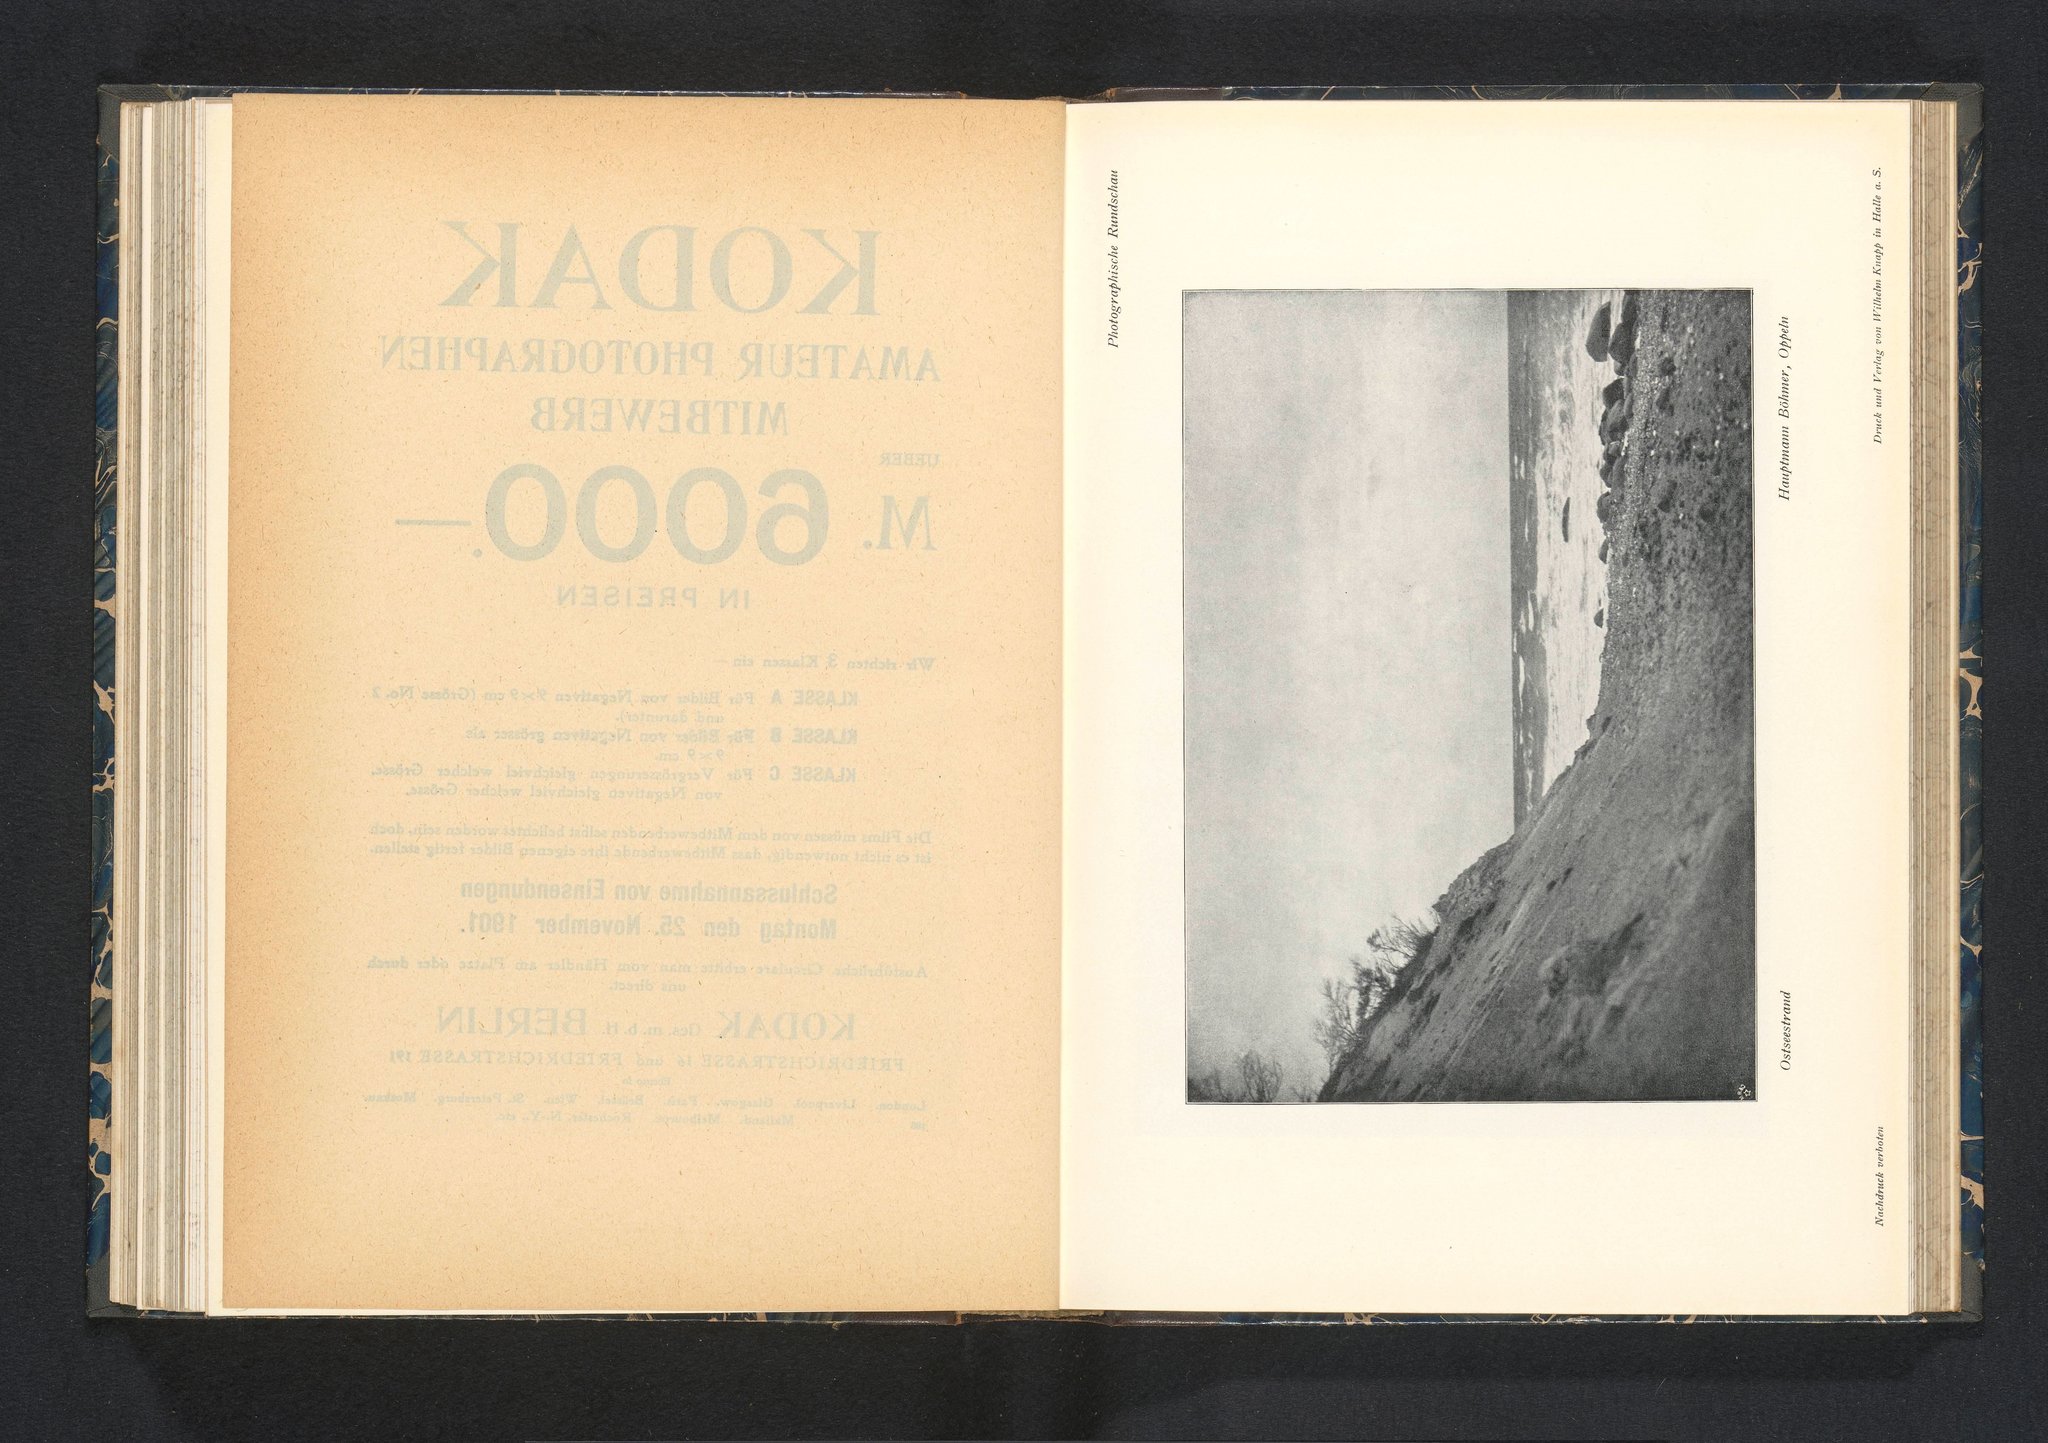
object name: photomechanical print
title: Kustlandschap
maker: hauptmann a. böhmer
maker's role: draughtsman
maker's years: 1860-1908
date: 1896-1901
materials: paper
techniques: autotype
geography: halle an der saale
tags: coast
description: Prent op vierde ongenummerde pagina na pagina 216.